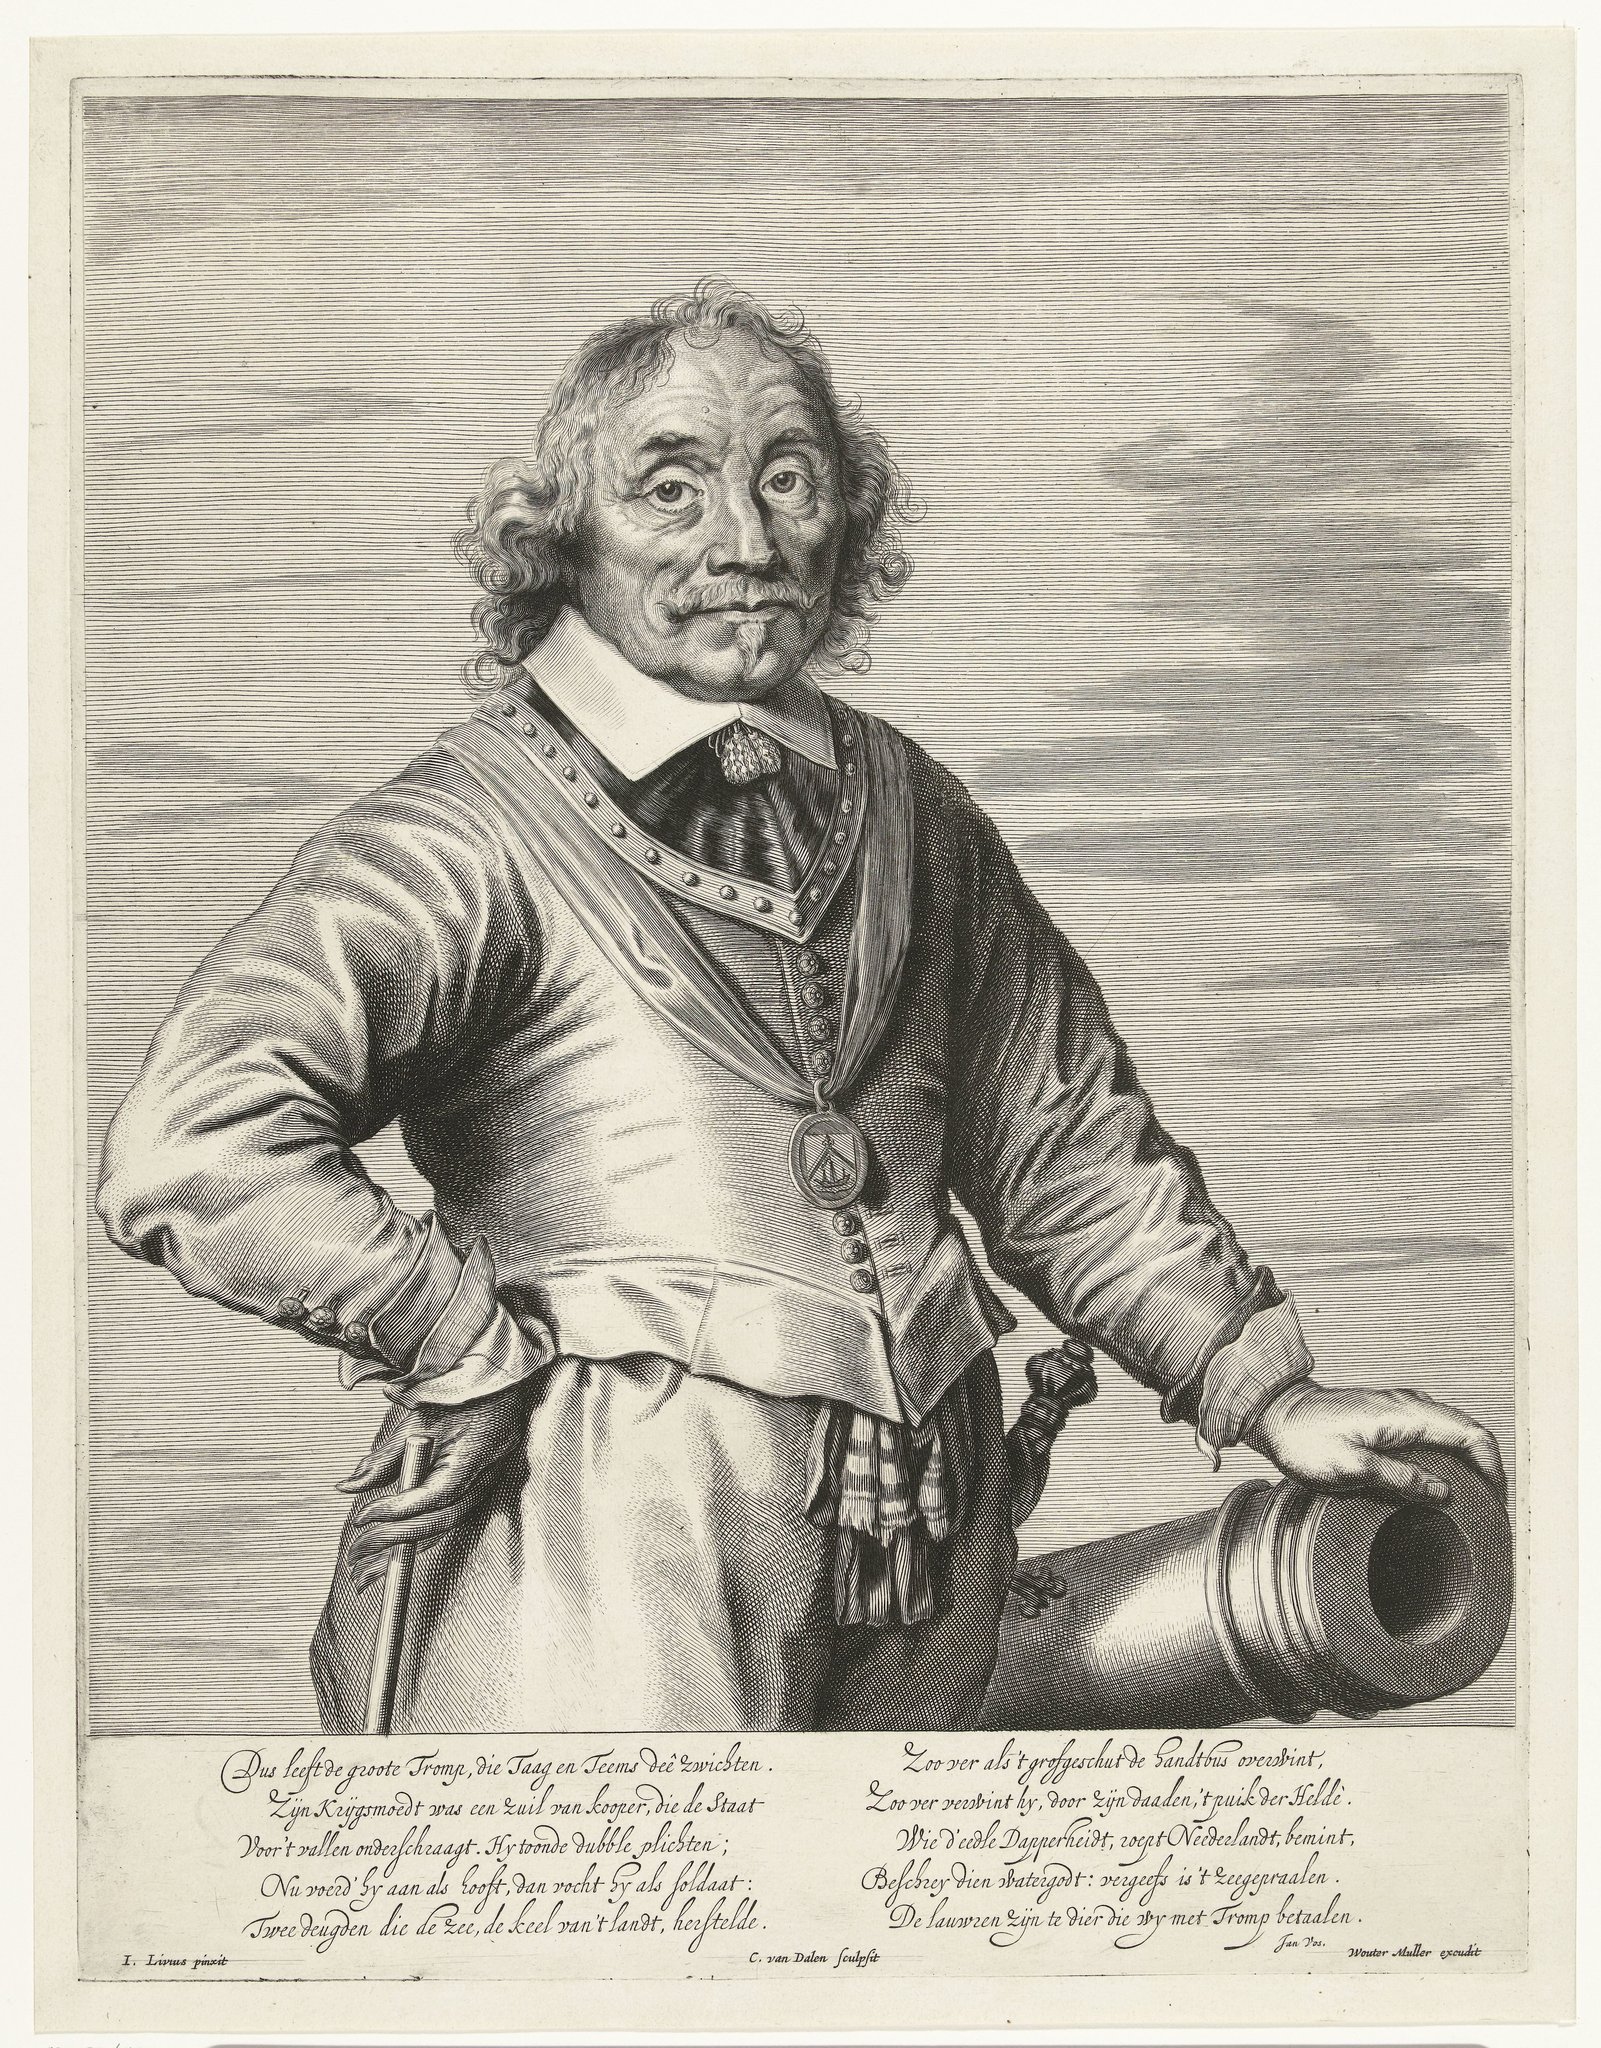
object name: print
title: Portret van Maarten Harpertszoon Tromp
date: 1648-1664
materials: paper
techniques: engraving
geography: amsterdam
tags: brielle, maarten harpertszoon tromp, historical persons, commander-in-chief, admiral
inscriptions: collector's mark: Lugt 2228, collector's mark: Lugt 240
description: Prent naar schilderij van Jan Lievens. Er zijn meer staten en bovendien kopieën van het portret bekend dan bij Hollstein vermeld worden.